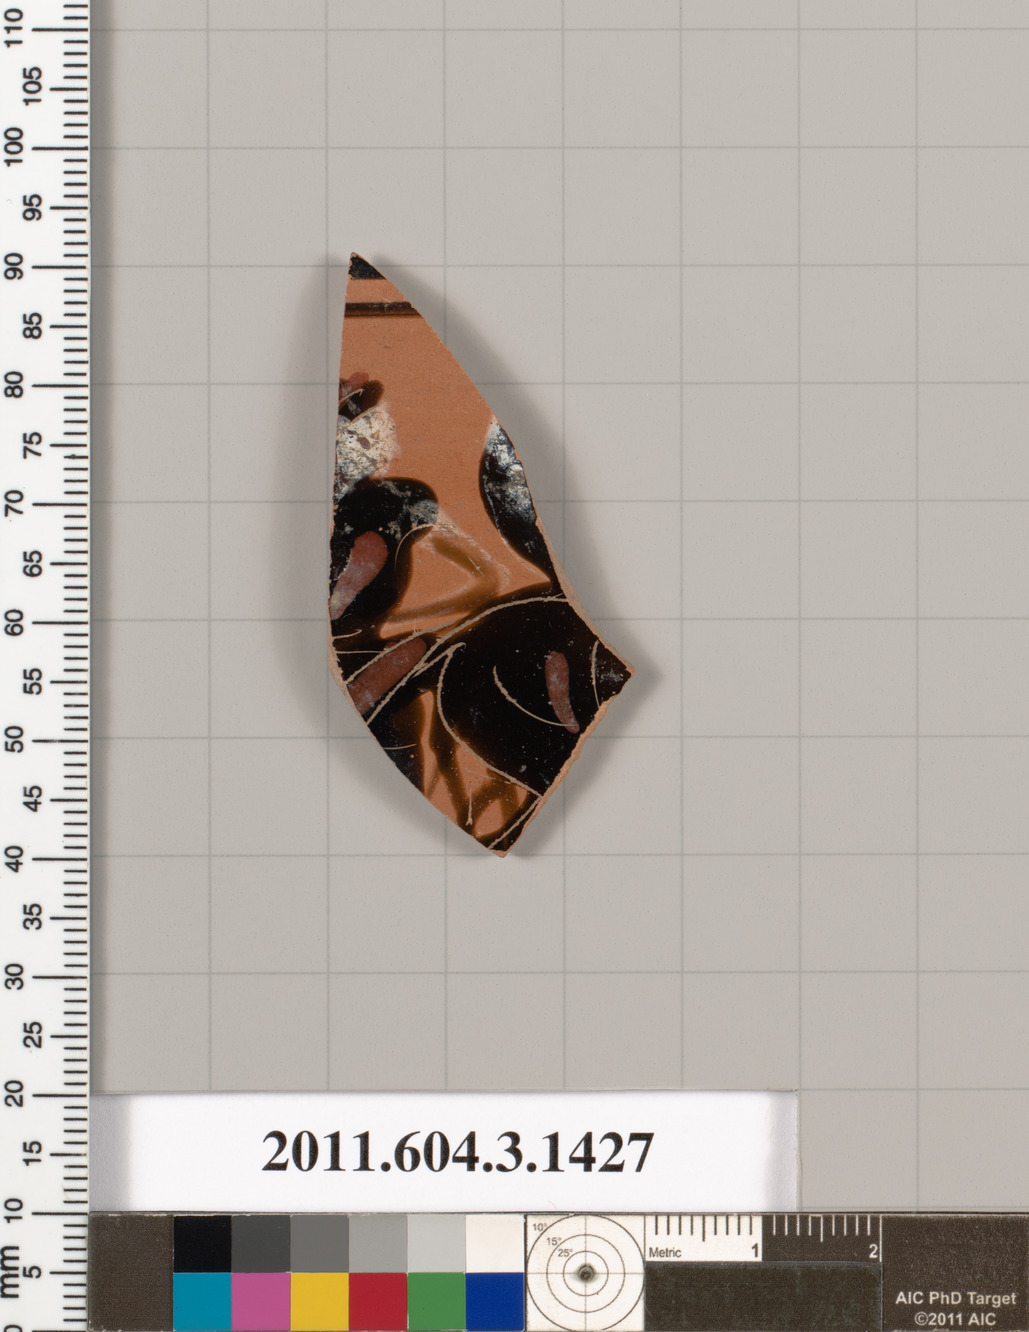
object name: skyphos fragment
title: Terracotta fragment of a skyphos (deep drinking cup)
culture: greek, attic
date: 500-468 BCE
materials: terracotta